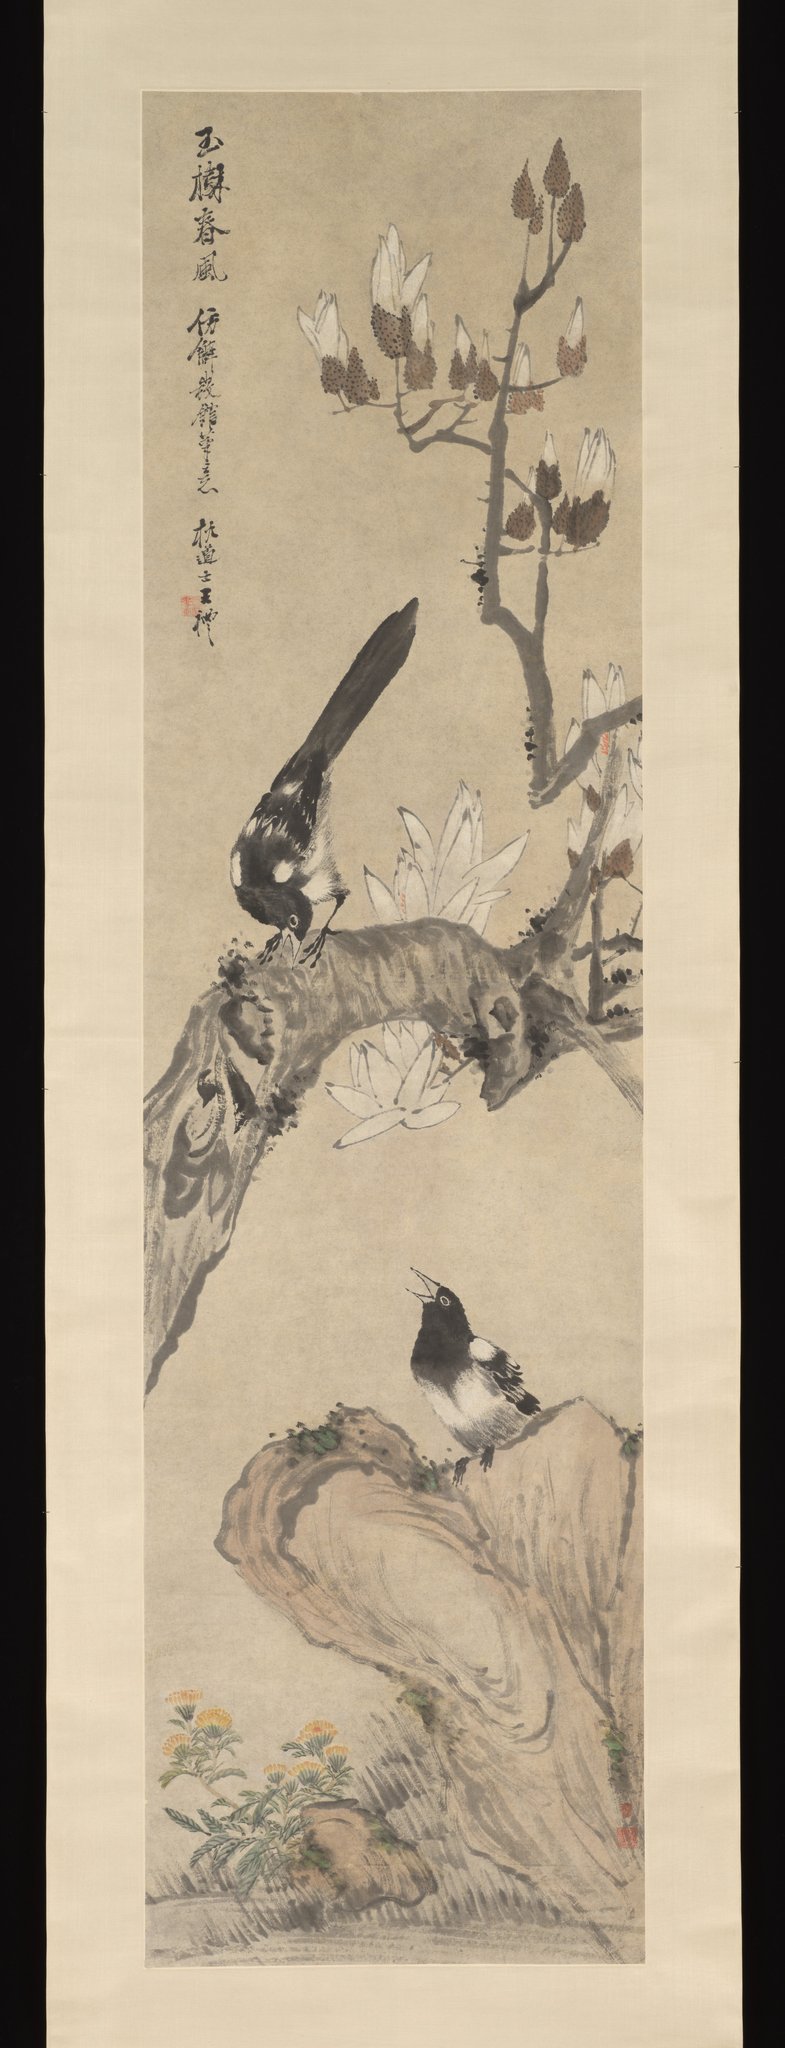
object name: hanging scroll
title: Magnolia and Mynahs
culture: chinese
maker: wang li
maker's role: artist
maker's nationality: chinese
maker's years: 1813-1879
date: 1813-1879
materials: ink, paper